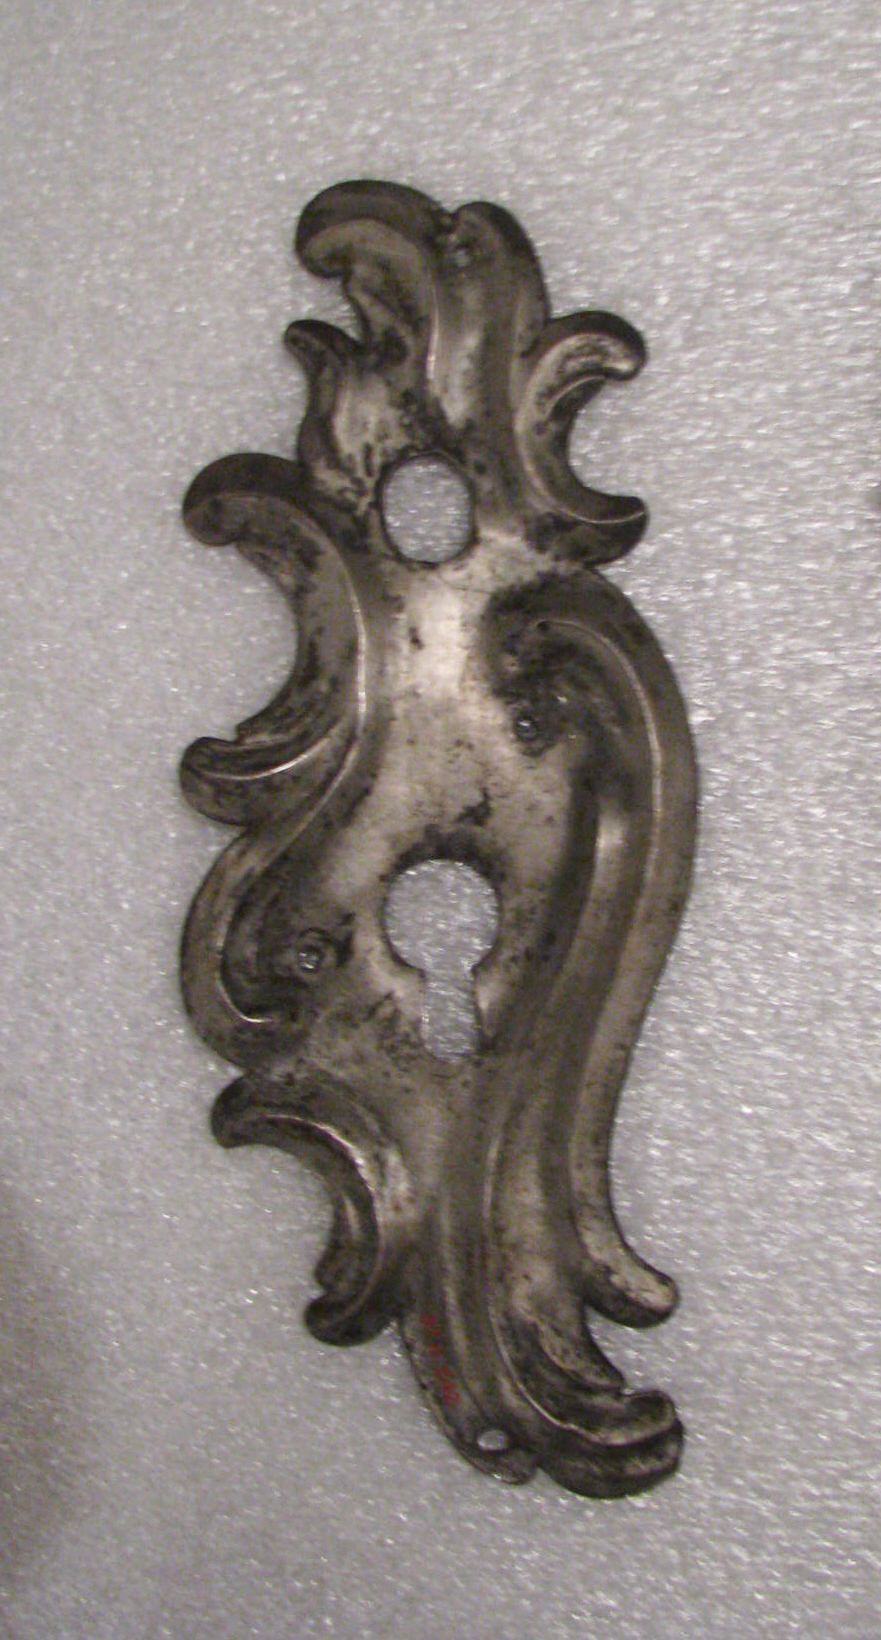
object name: escutcheon with lock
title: Escutcheon of lock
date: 1740-1760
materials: iron